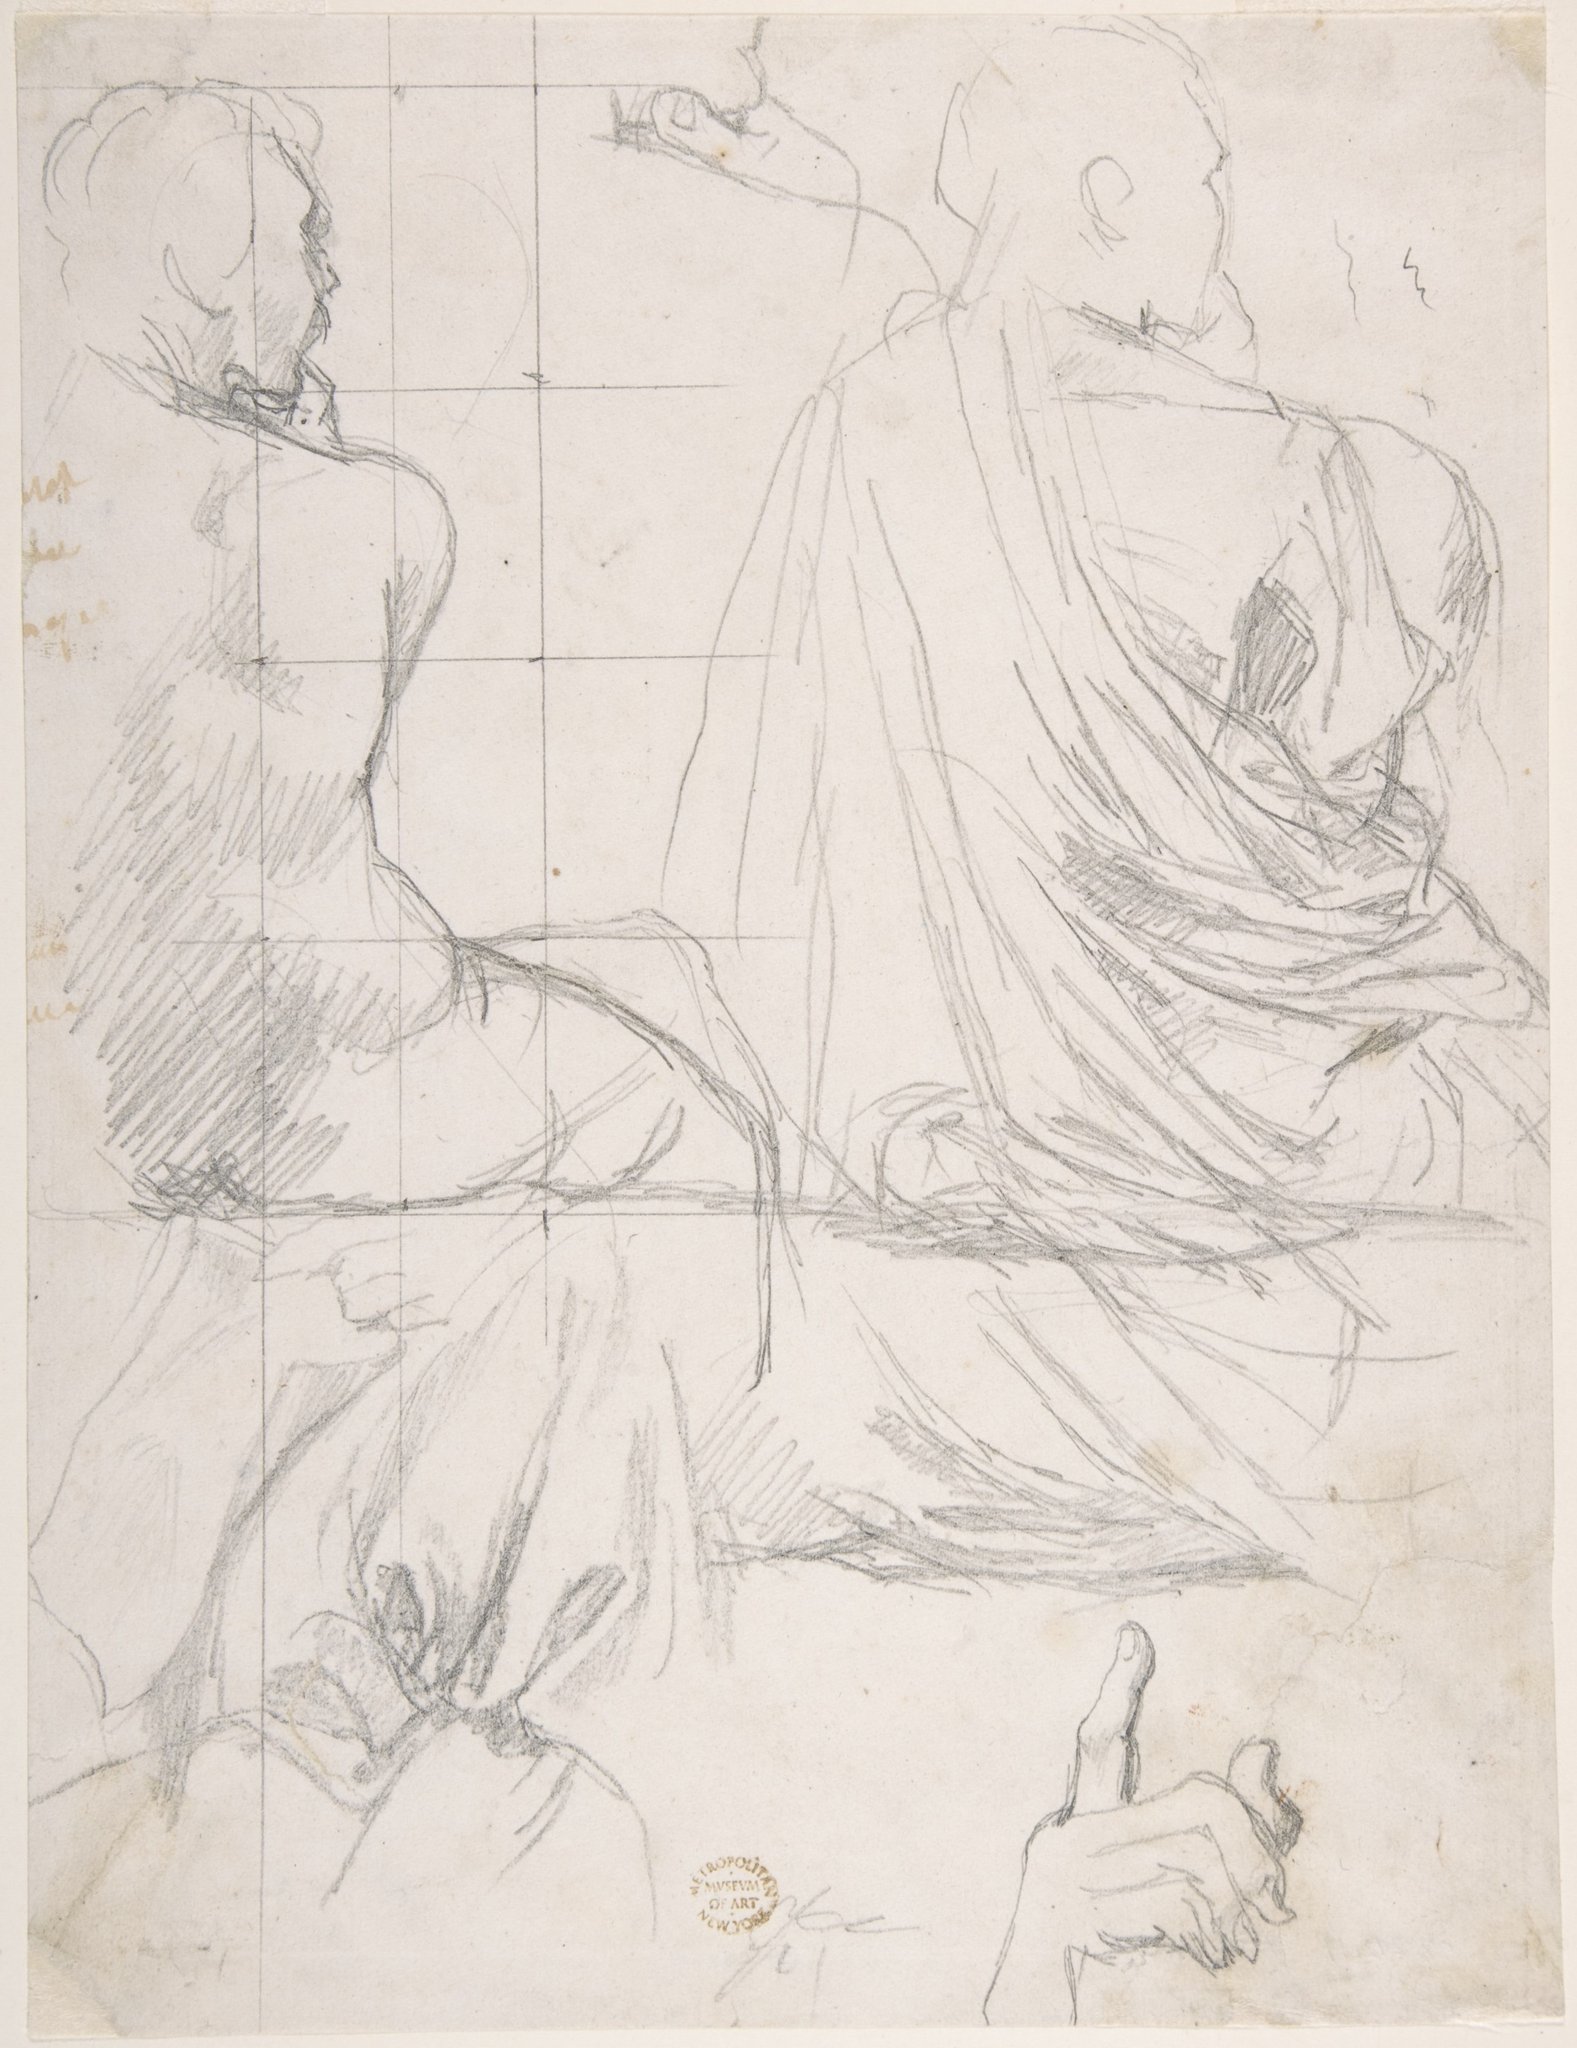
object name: drawing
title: Study of Figures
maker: jean auguste dominique ingres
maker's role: artist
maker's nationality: french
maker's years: 1780-1867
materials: graphite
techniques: drawing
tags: human figures,hands